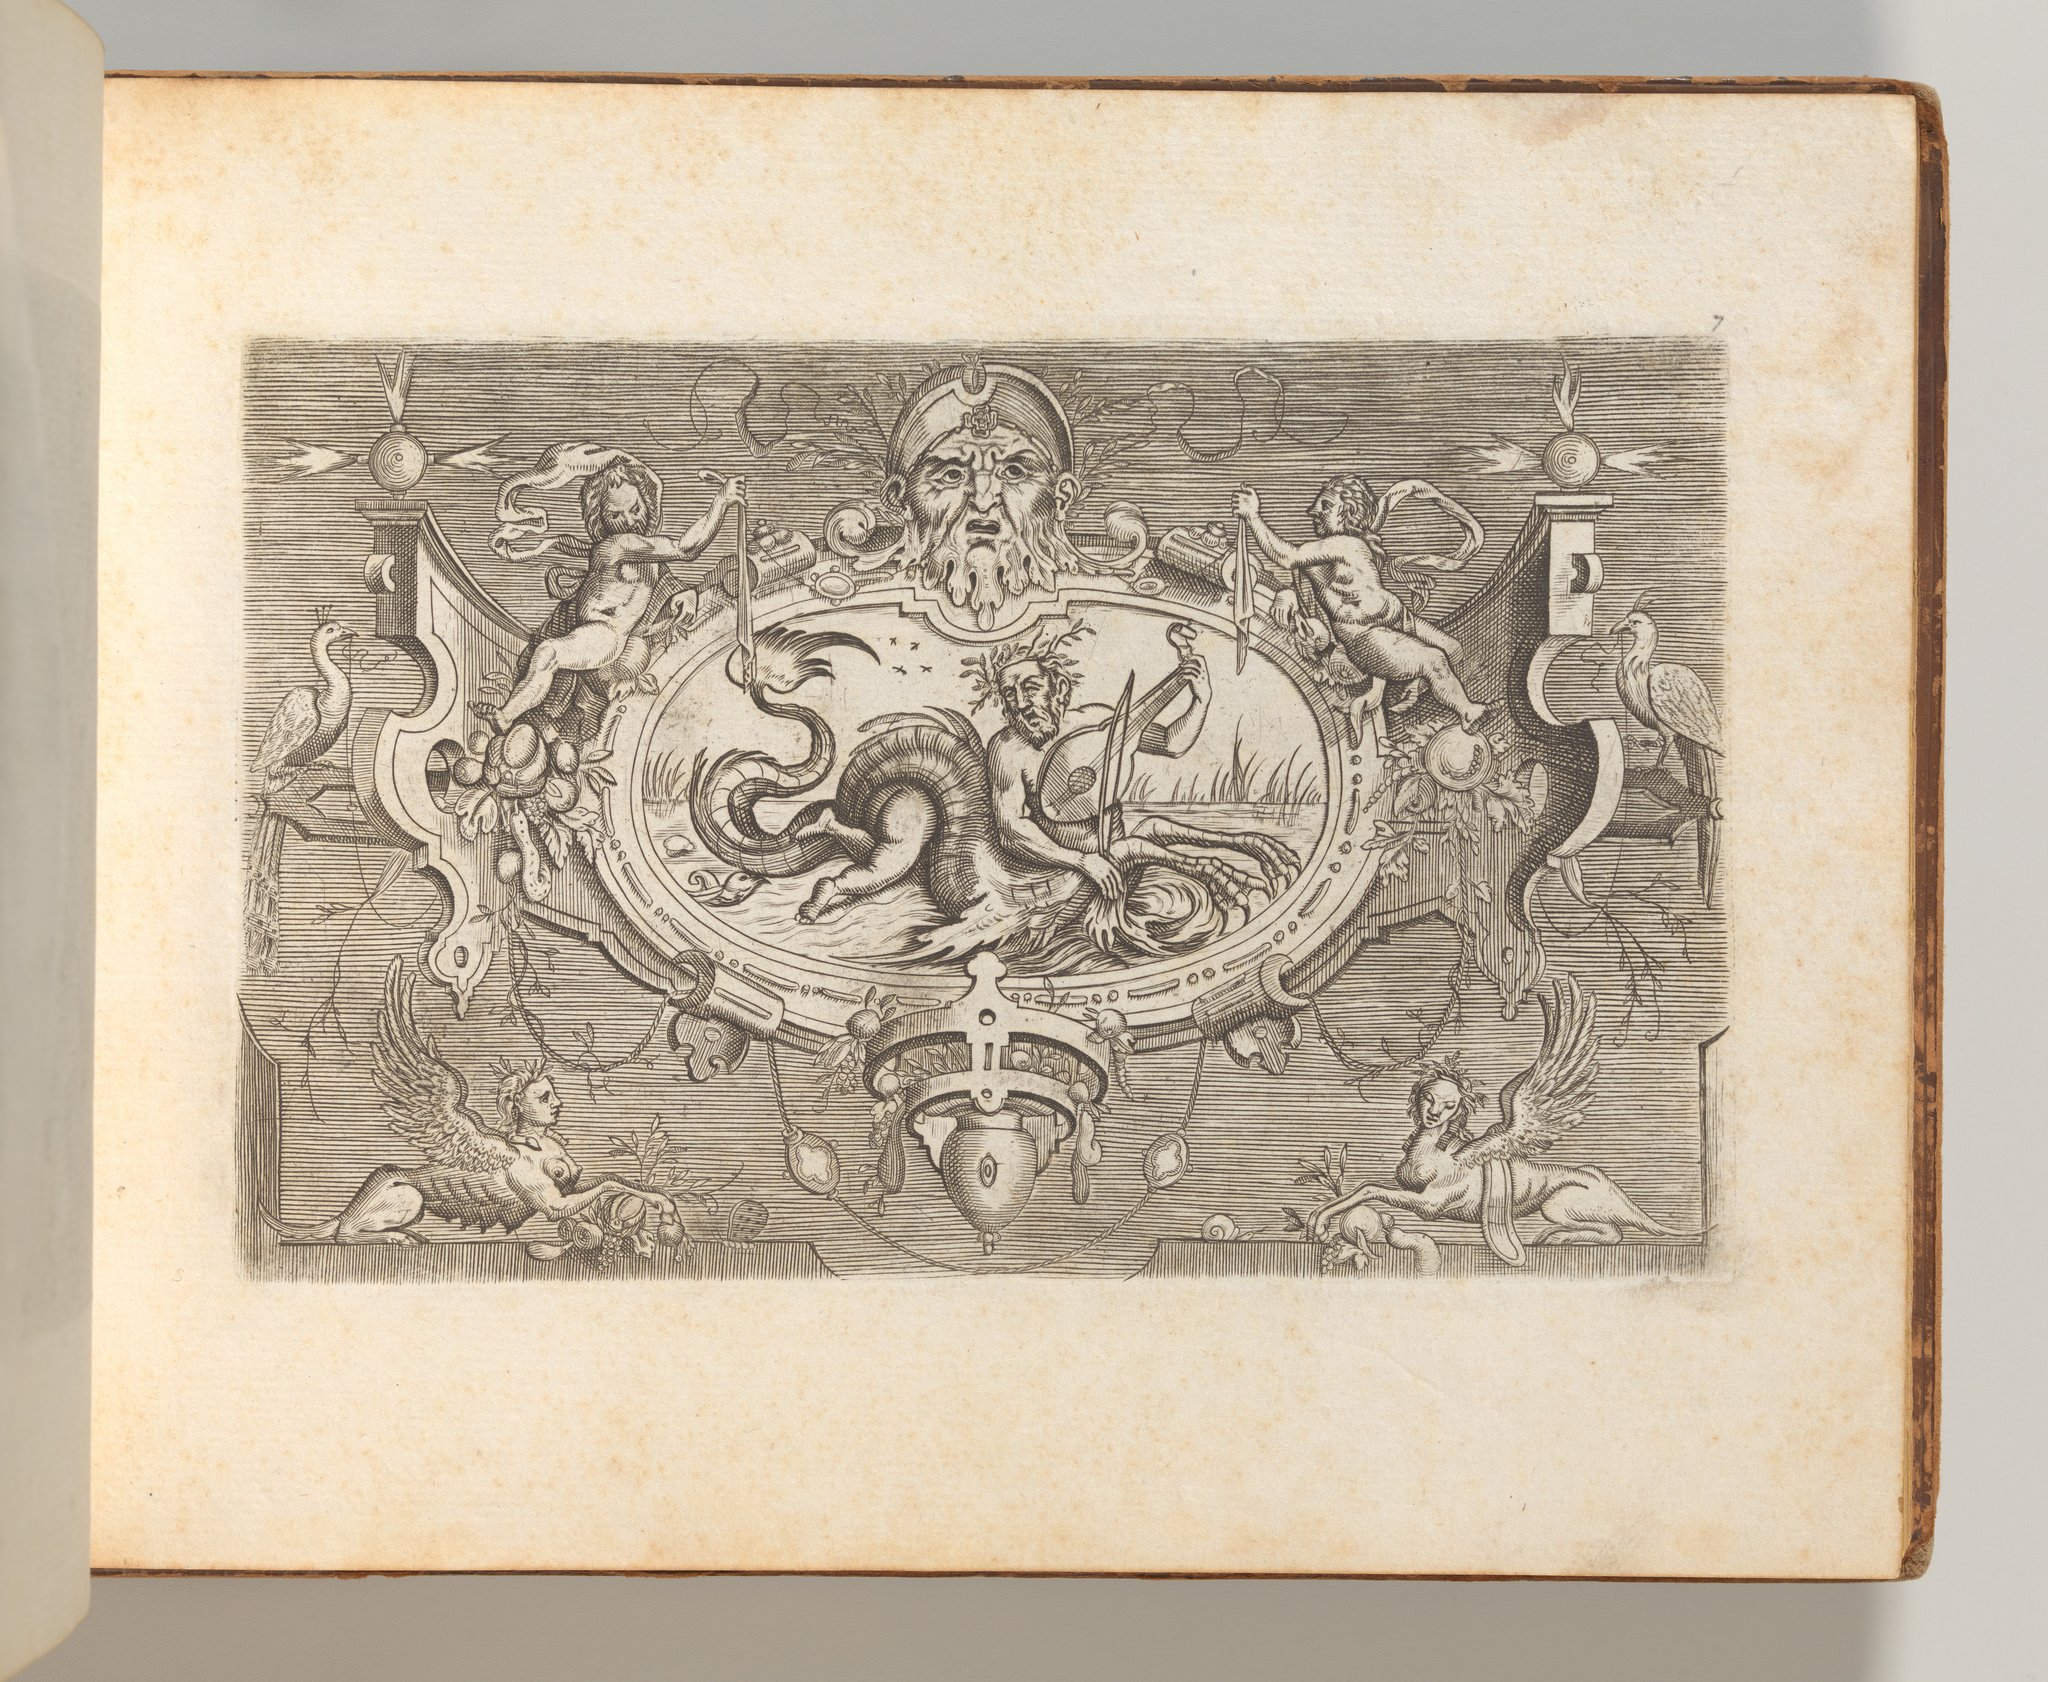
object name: album print ornament architecture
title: Targhe ed altri ornati di varie e capricciose invenzioni (Cartouches and other ornaments of various and capricious invention, page 7)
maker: jacob floris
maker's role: artist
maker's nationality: central european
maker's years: 1524-1581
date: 1773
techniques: engraving, etching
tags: cartouches,faces,peacocks